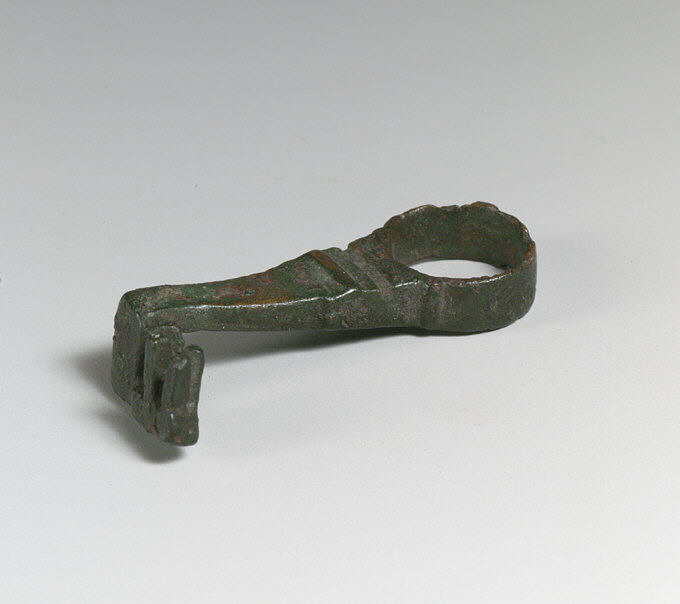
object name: key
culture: roman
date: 670 BCE-330 CE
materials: bronze